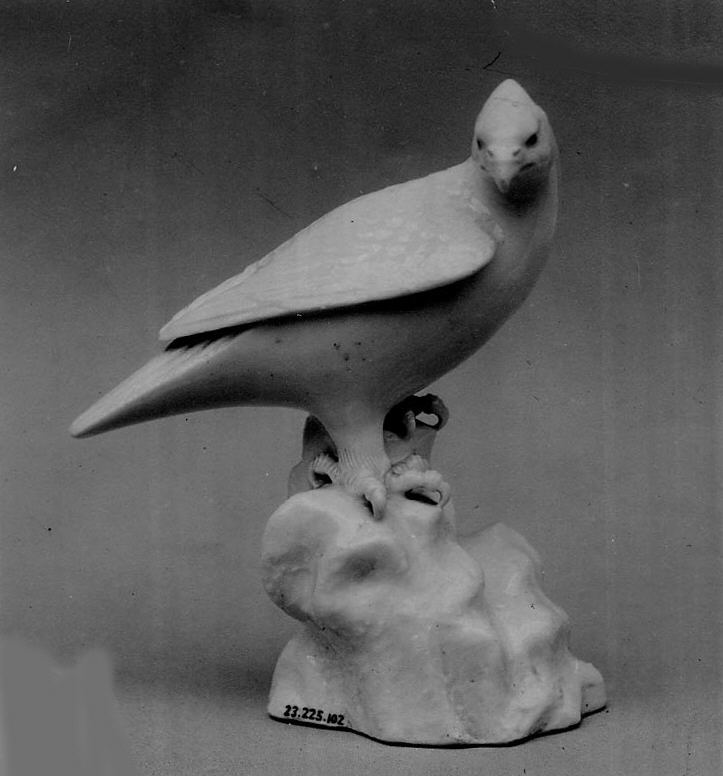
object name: figure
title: Eagle on rock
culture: japanese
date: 1830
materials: porcelain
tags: eagles